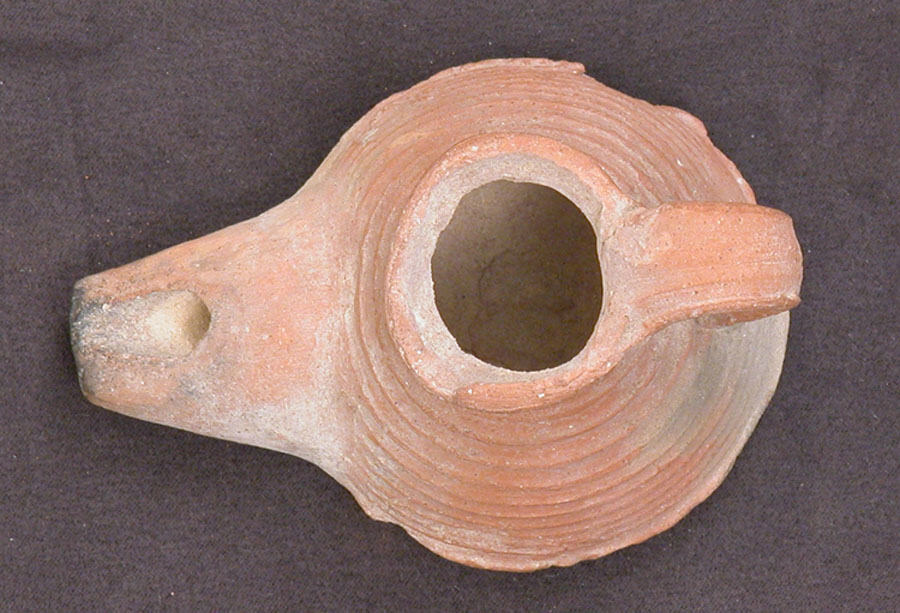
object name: lamp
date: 501-800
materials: earthenware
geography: palestine